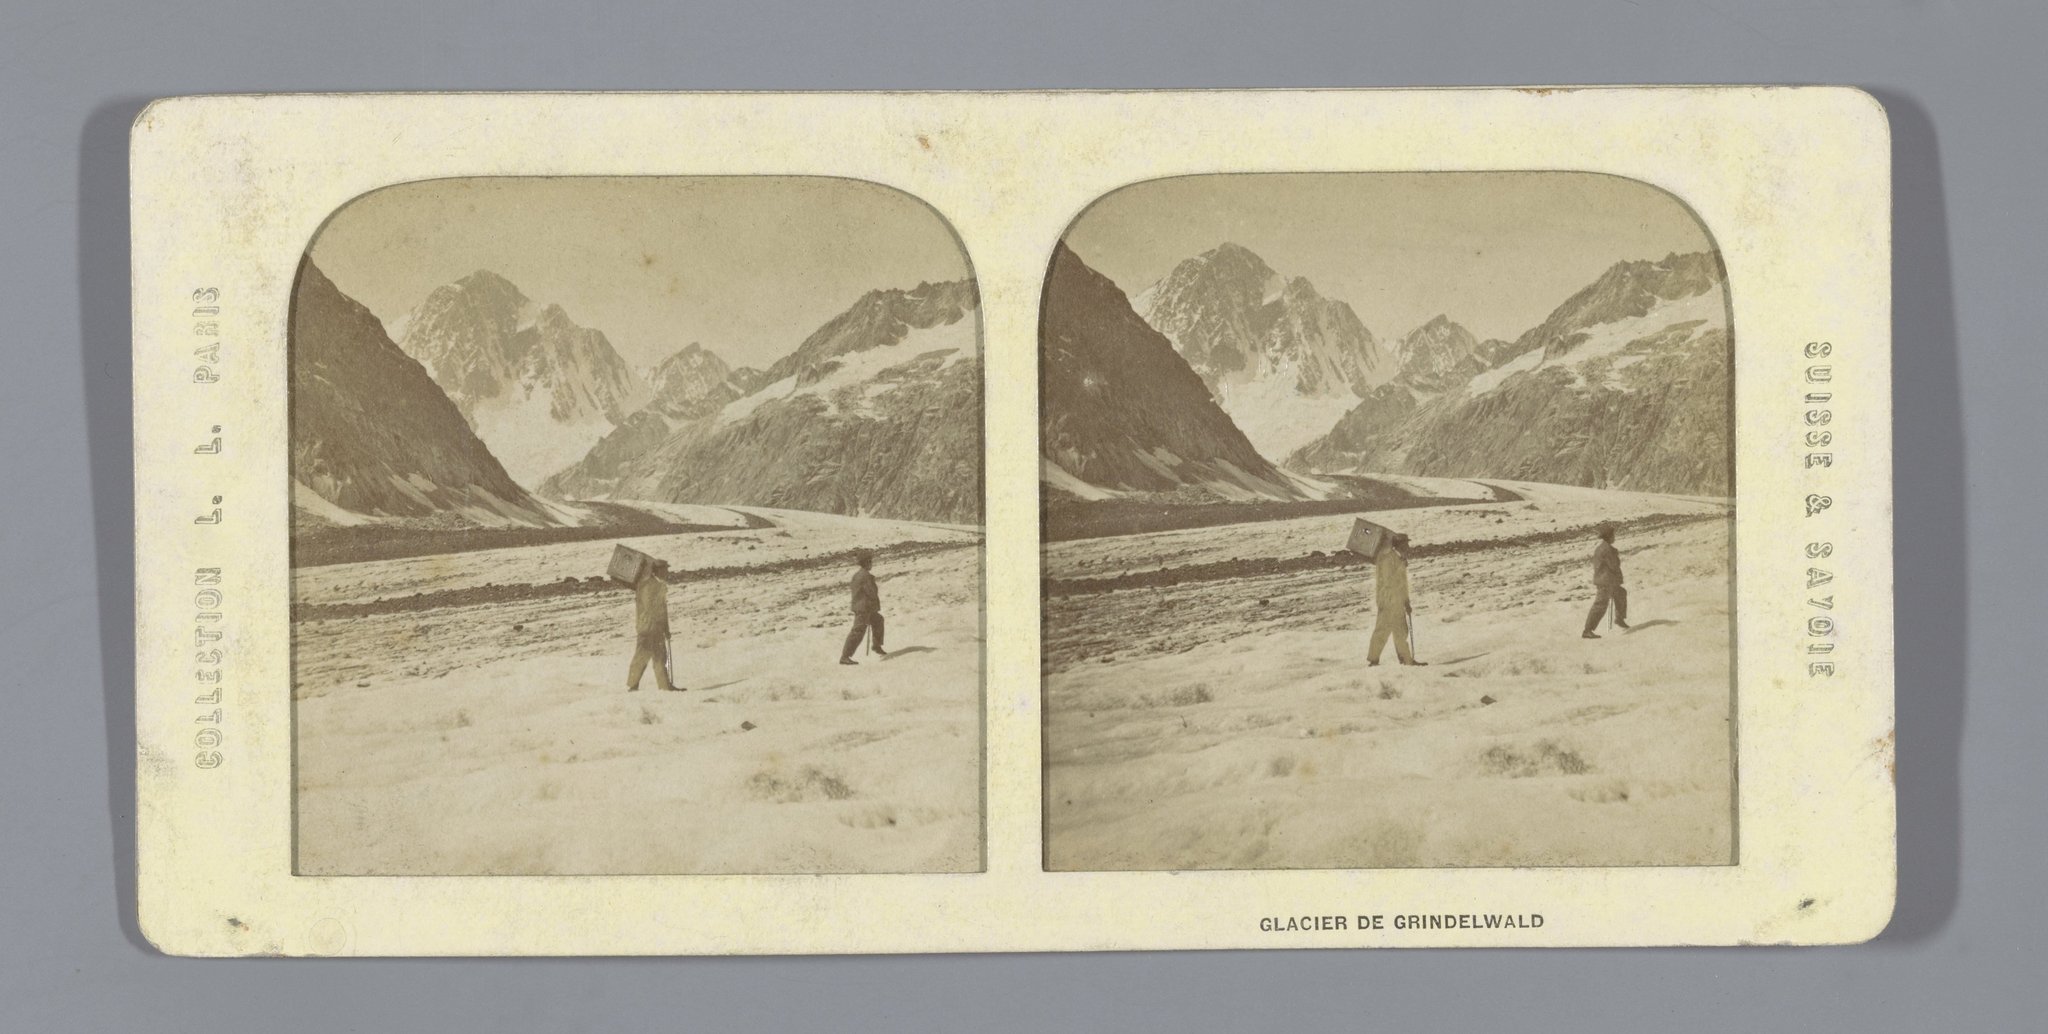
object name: tissue stereograph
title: Glacier de Grindelwald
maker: Anonymous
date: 1864-1875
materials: cardboard, paper, photographic support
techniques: albumen print, cutting, hand coloring, perforating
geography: grindelwald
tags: glacier (+ landscape with figures, staffage)